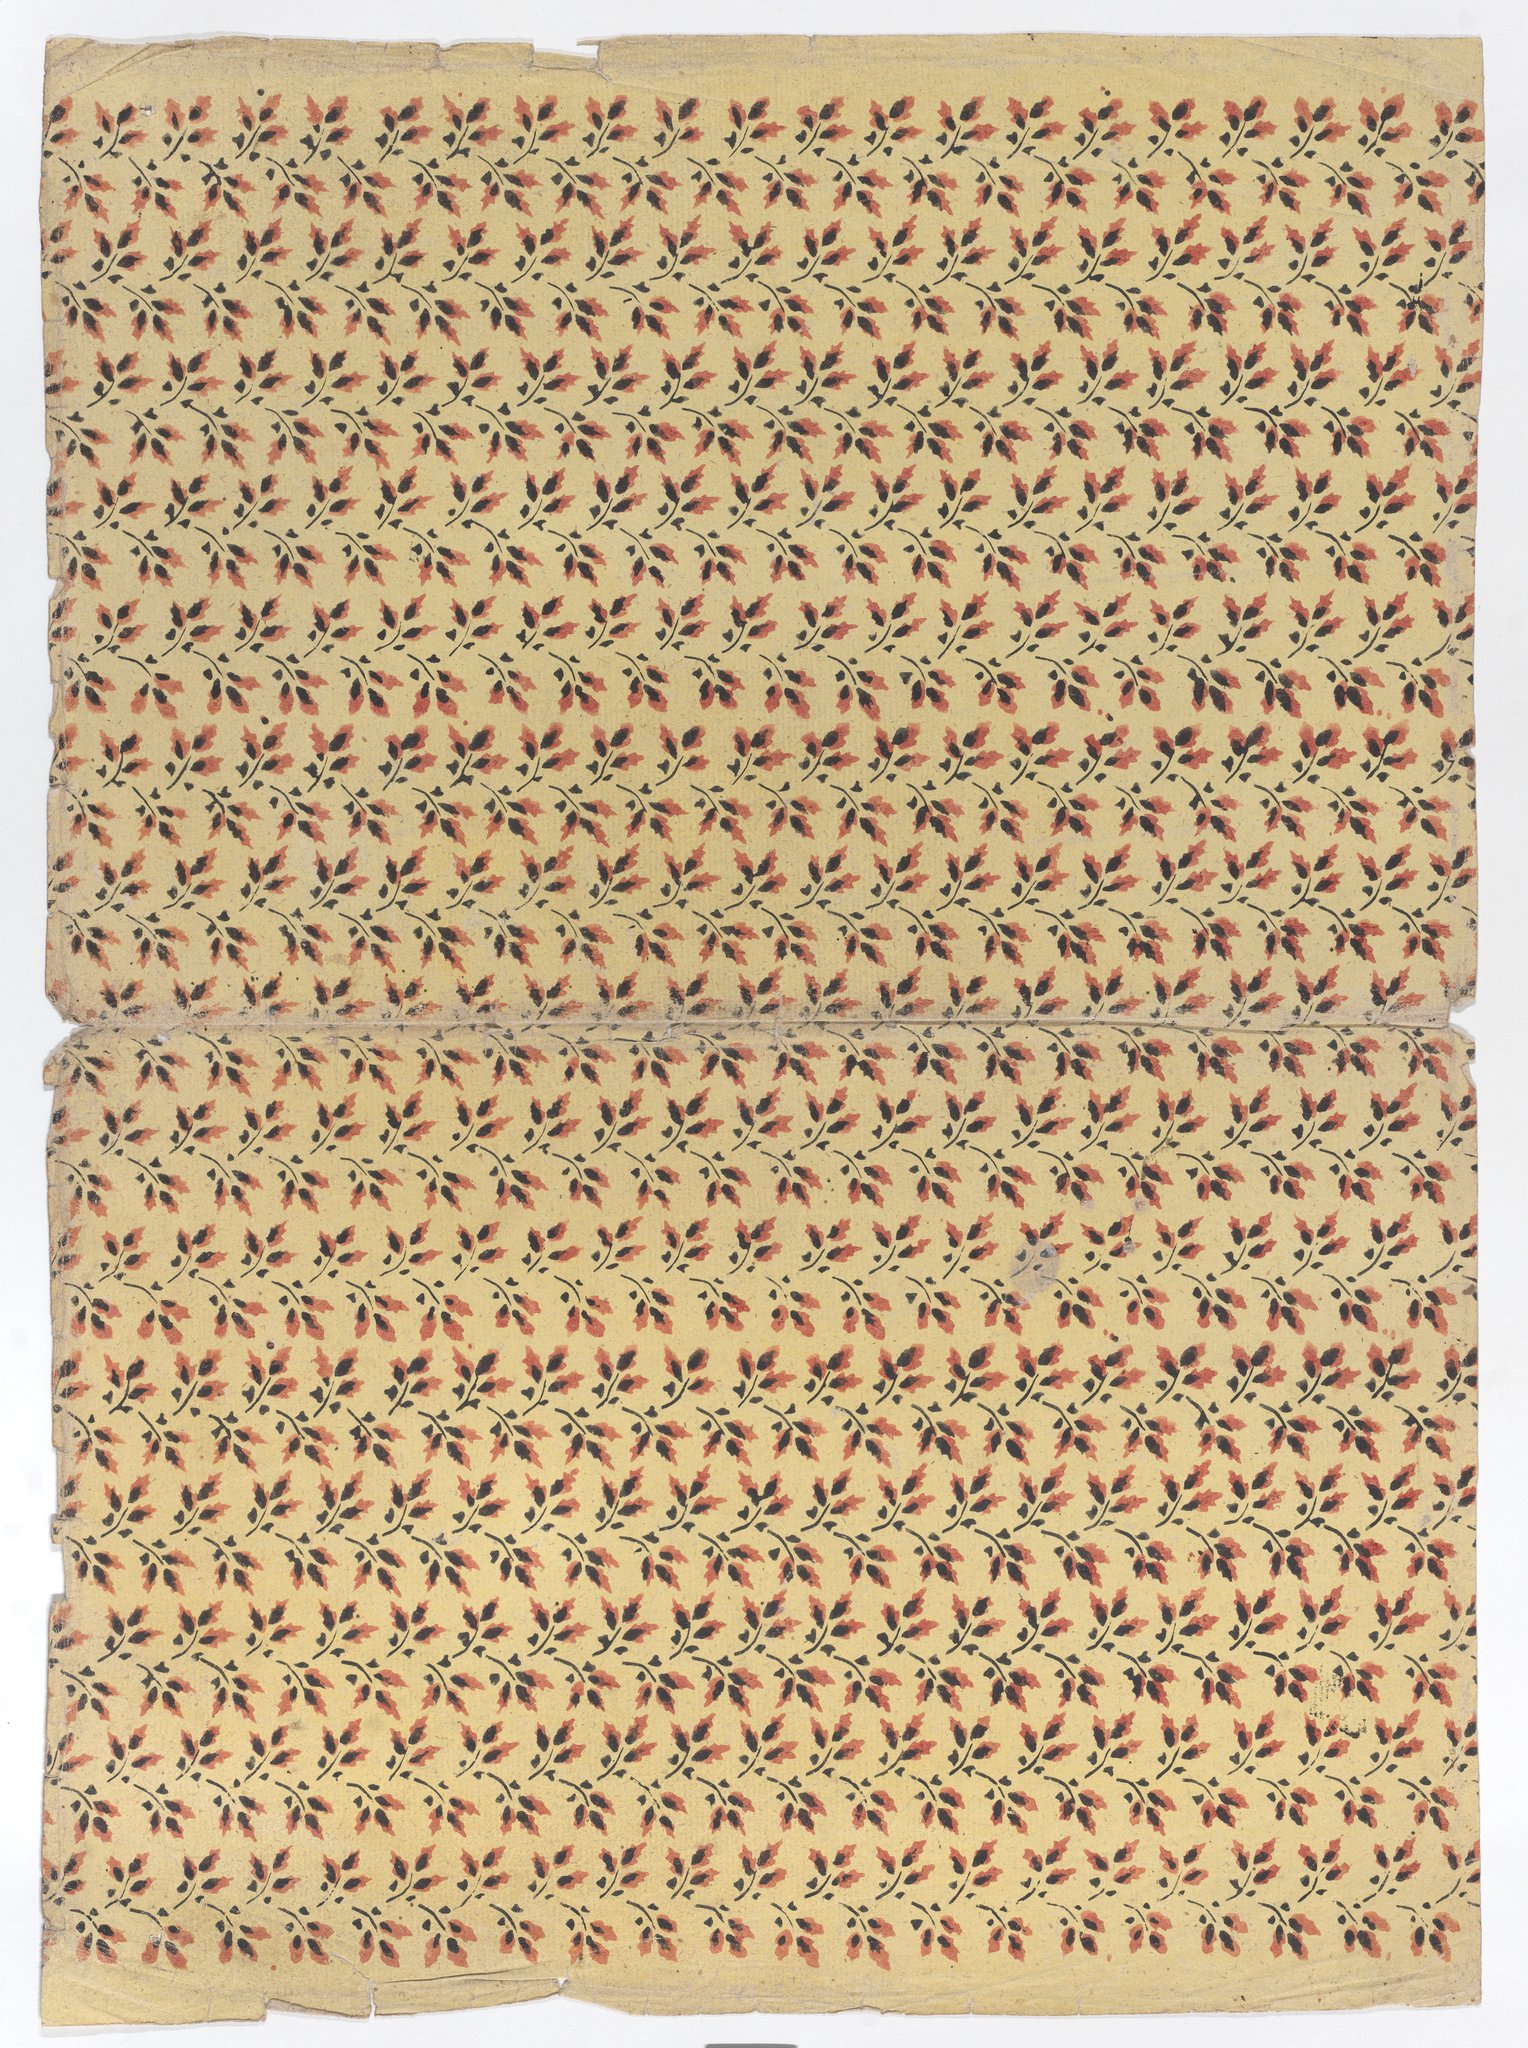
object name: print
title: Book cover with overall pattern of leaves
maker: Anonymous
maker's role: artist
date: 1801-1900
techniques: relief print